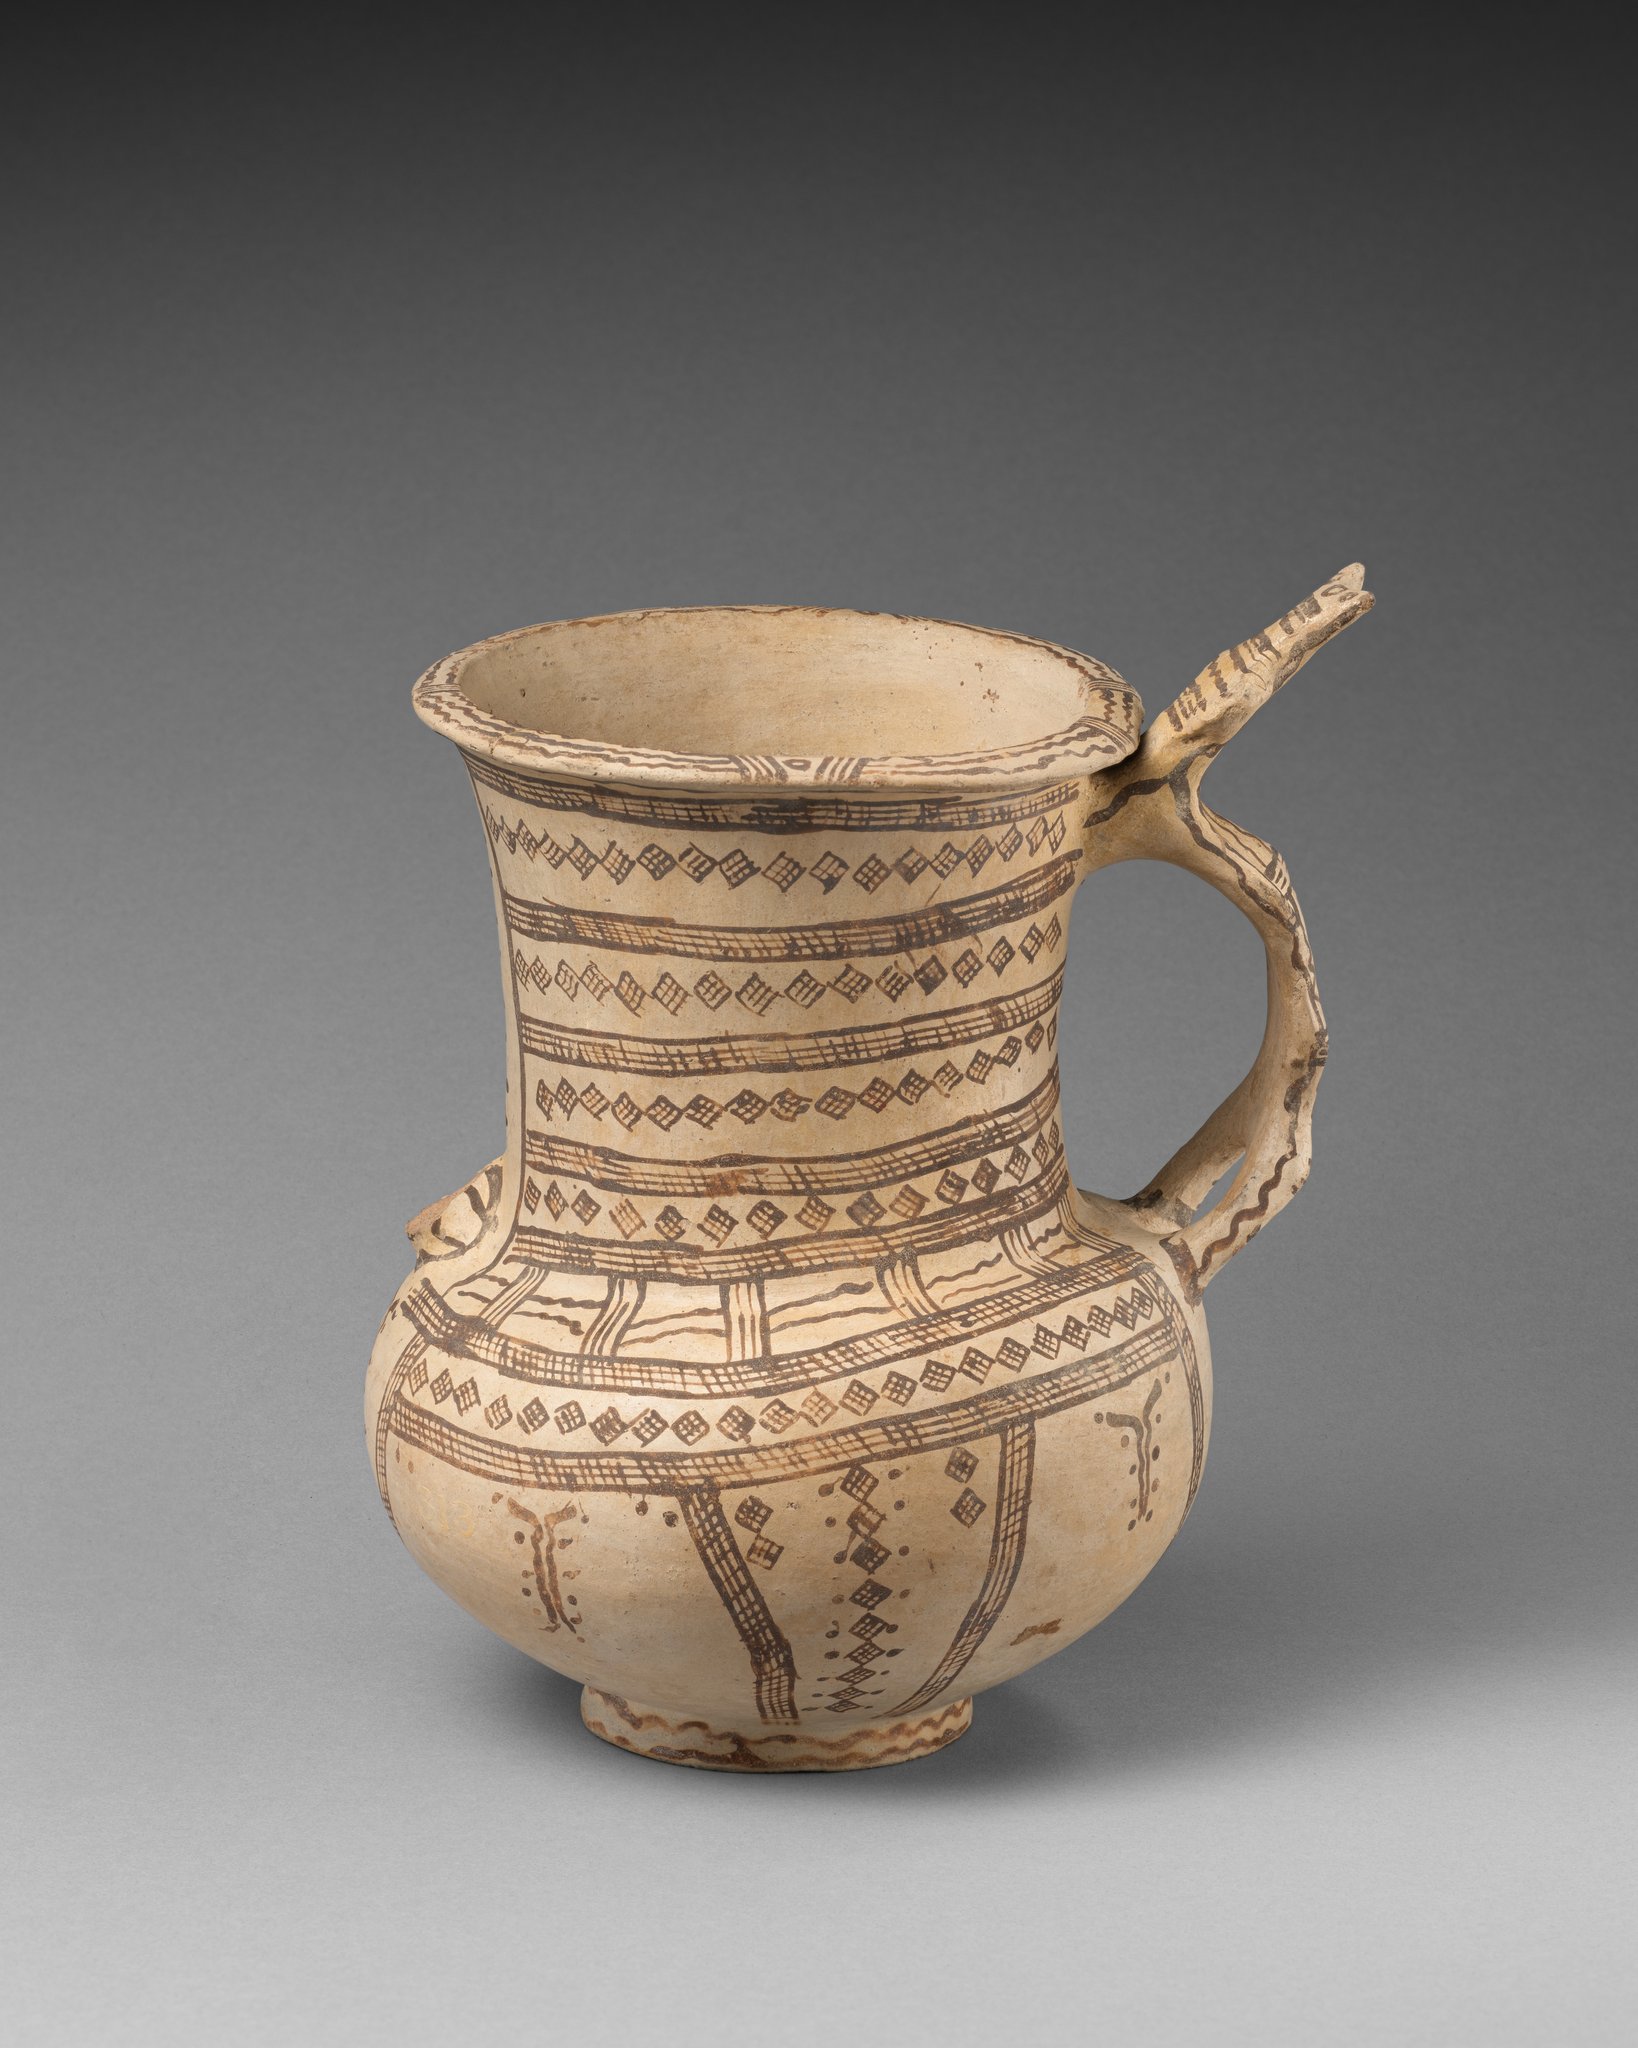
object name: tankard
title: Terracotta tankard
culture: cypriot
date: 1600-1450 BCE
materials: terracotta